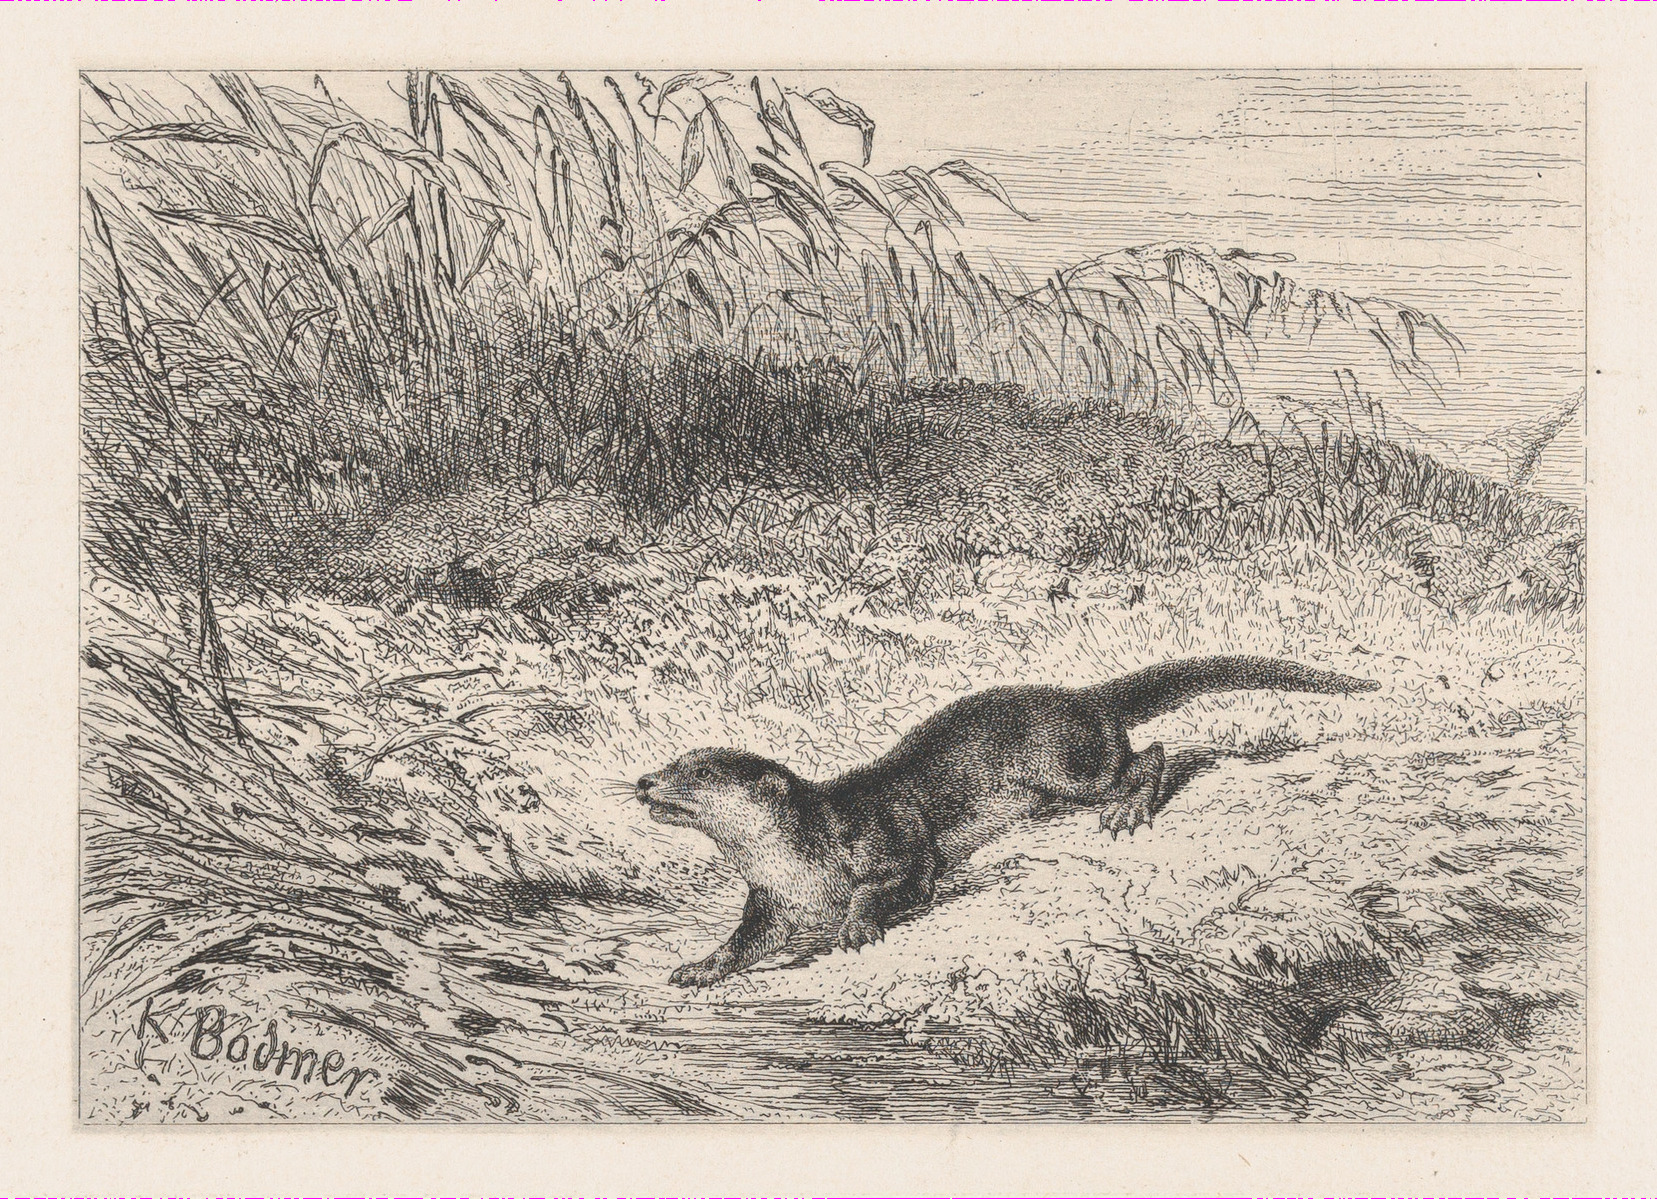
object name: print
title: An Otter, from "Eaux-Fortes Animaux & Paysages"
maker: karl bodmer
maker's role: artist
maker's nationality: swiss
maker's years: 1809-1893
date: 1860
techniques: etching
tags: animals